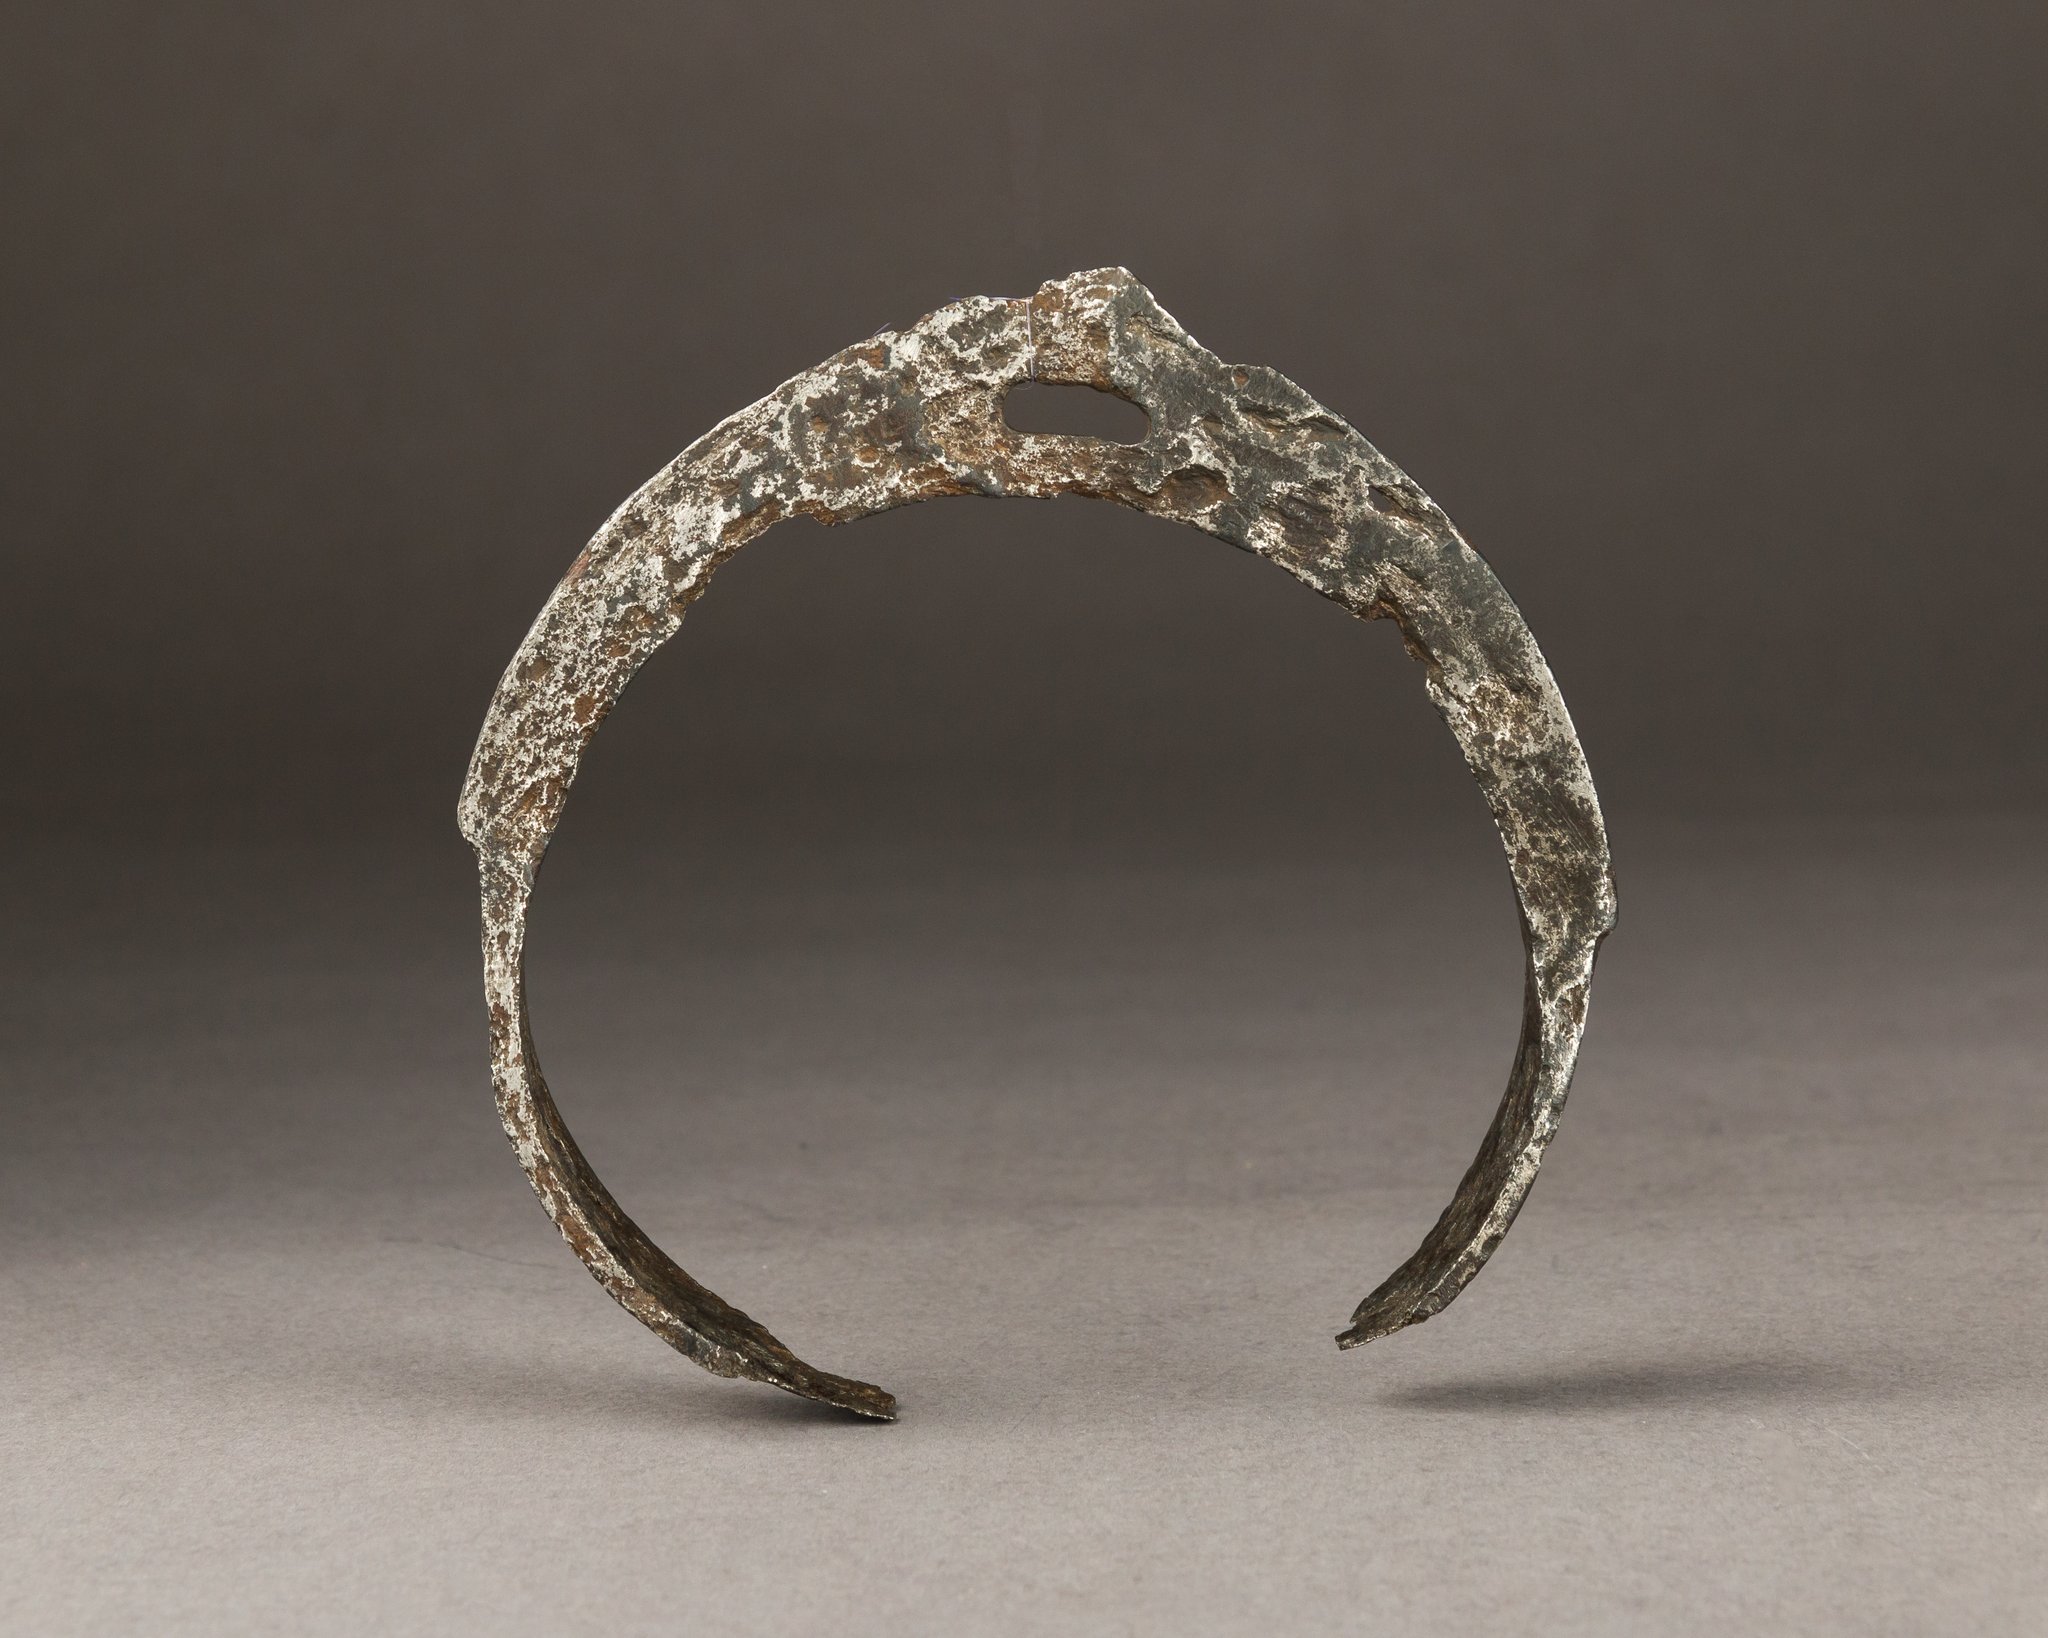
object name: stirrup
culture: west slavic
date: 901-1200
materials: iron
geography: poland